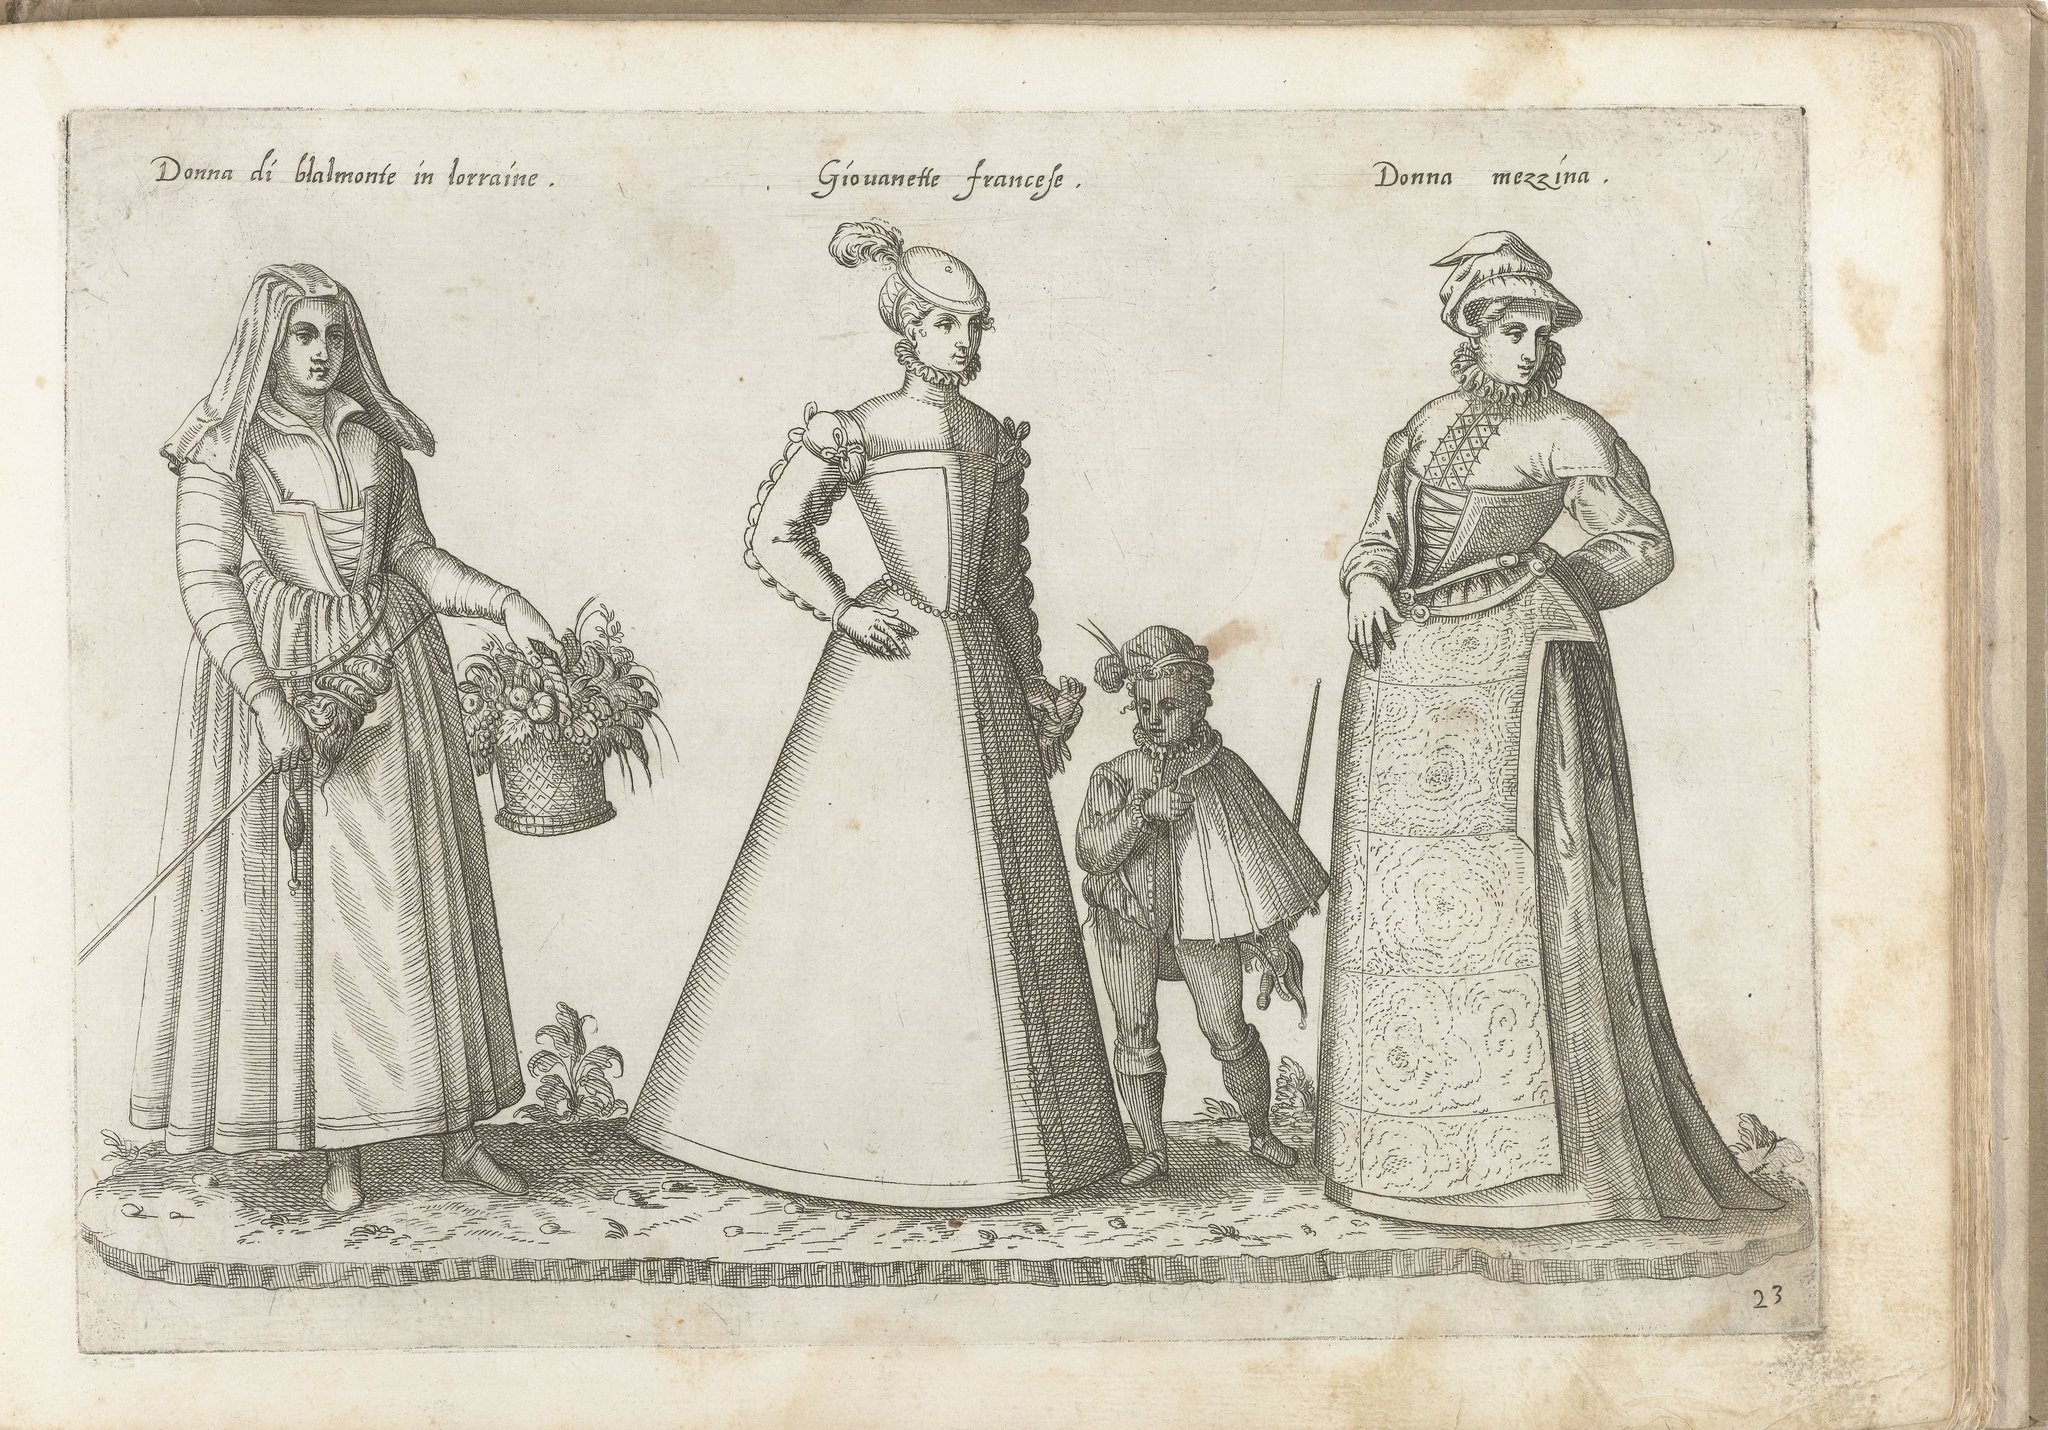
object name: costume print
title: Donna di blalmonte in lorraine / Giovanette francese / Donna mezzina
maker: bartolomeo grassi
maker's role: publisher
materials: paper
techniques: engraving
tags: europeans (with name) (+ costume), cut flowers; nosegay, bunch of flowers, clothes, costume (+ children's clothes), walking-stick, staff, cane (+ women's clothes), veil (+ women's clothes), fruit, clothes, costume (+ women's clothes), head-gear: hat (+ women's clothes), carrying something in basket, bag, rucksack, etc., container made of plant material other than wood: basket, skirt (+ women's clothes), dress, gown (+ women's clothes), apron (+ women's clothes), clothing for the upper part of the body (with name) (+ women's clothes)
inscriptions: number: ‘22’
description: Prent nr. 23 uit album 'Dei veri ritratti degl'habiti di tvtte le parti del mondo intagliati in rame per opra di Bartolomeo Grassi', 1585.